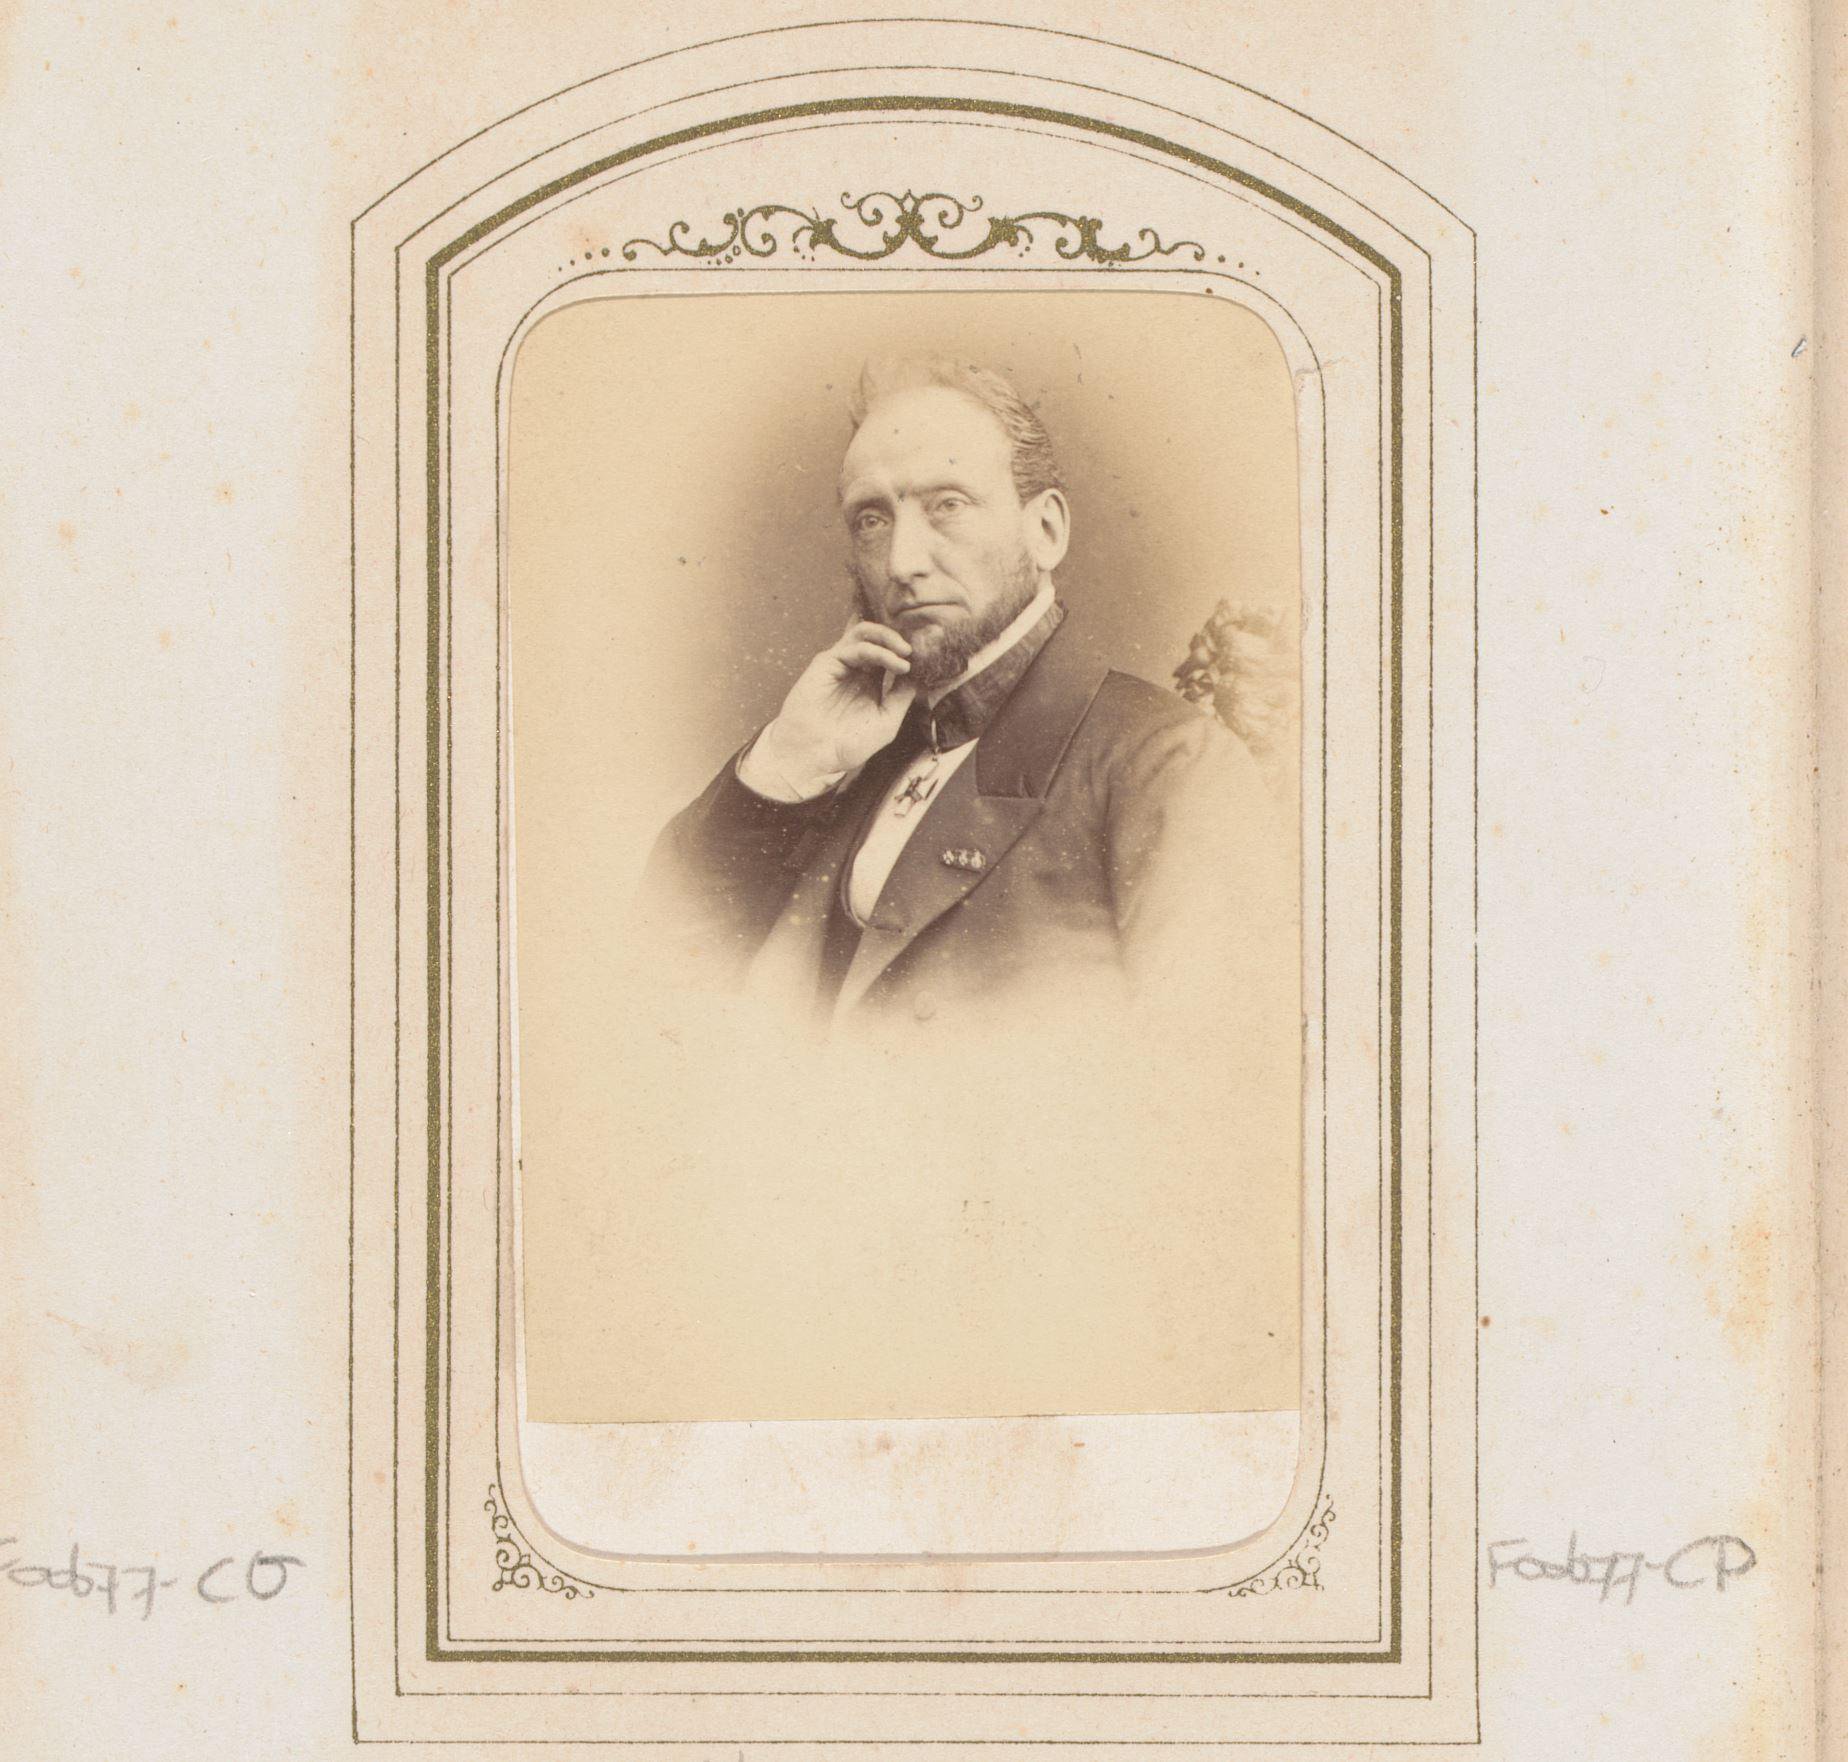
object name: photograph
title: Portret van Jan Messchert van Vollenhoven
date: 1866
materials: cardboard, photographic support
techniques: albumen print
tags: amsterdam, mayor, historical persons, politician, e.g. party leader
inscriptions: dedication: ‘Uit erkentelijkheid/ en/ tot vriendschappelijk/ aandenken/ 26 July 1866./ v. Vollenhoven’, annotation: ‘v Vollenhoven/ (opdracht 1866)’, inscription: ‘PHOTOGr ATELIER/ WEGNER & MOTTU./ KALVERSTRAAT/ Over den Heyligenweg D. 26/ AMSTERDAM’